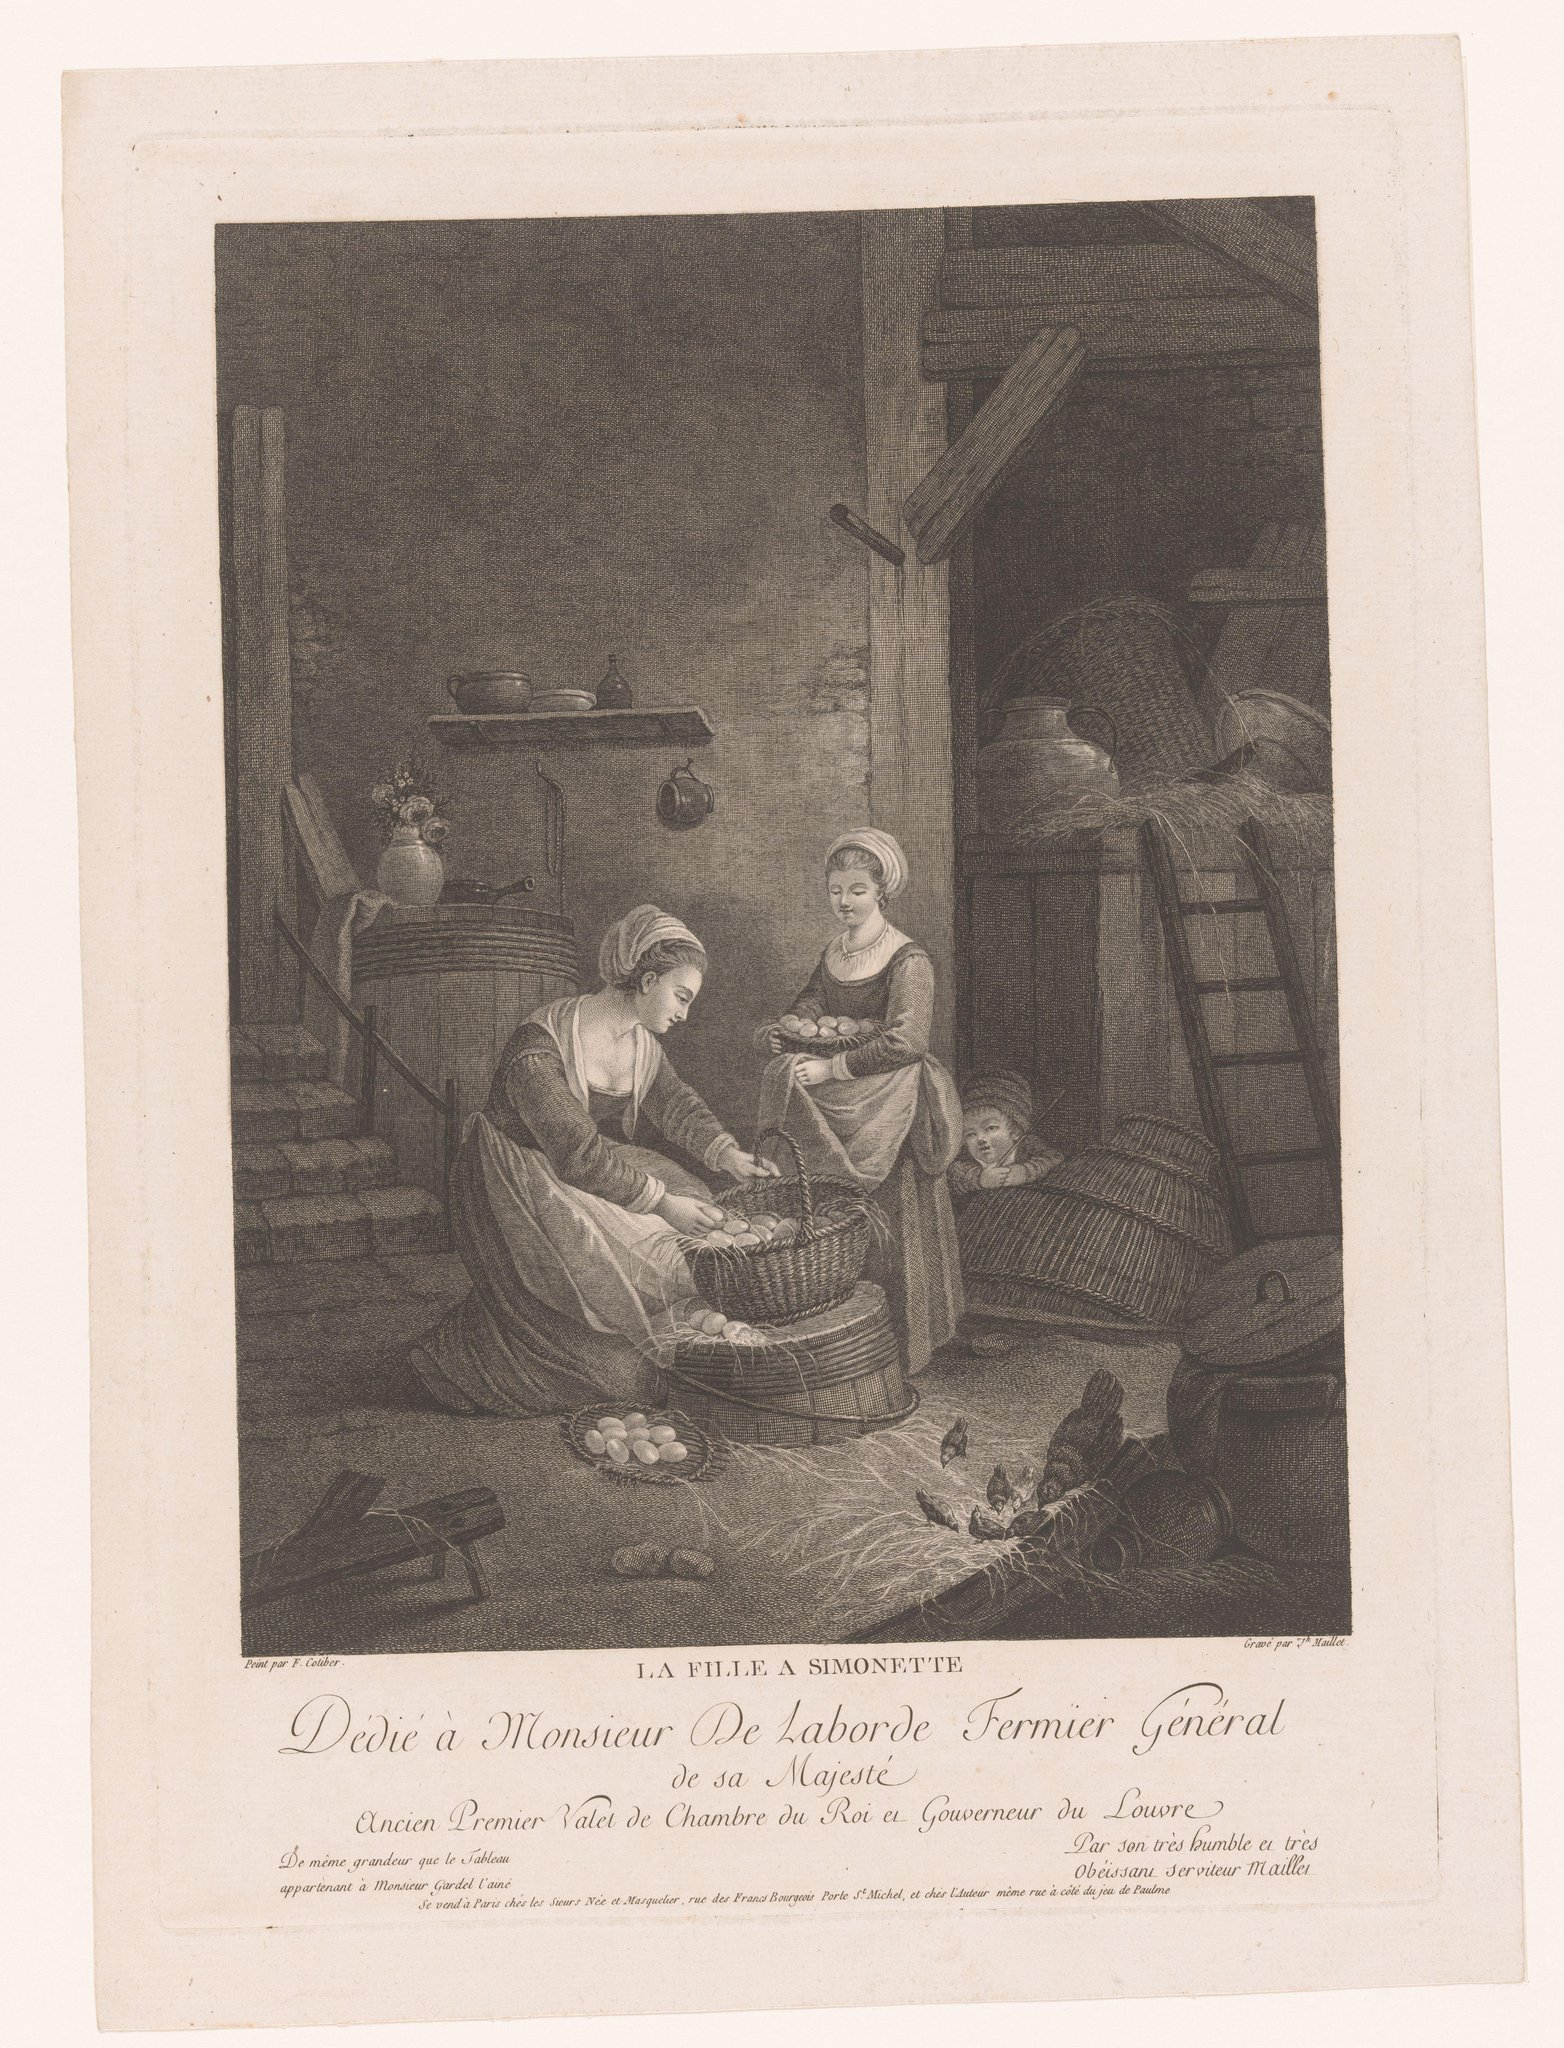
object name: print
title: La fille a Simonette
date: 1761-1811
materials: paper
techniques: engraving, etching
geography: paris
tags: eggs, egg-dishes, maid ~ house personnel, chicken house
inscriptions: collector's mark: Lugt 2228